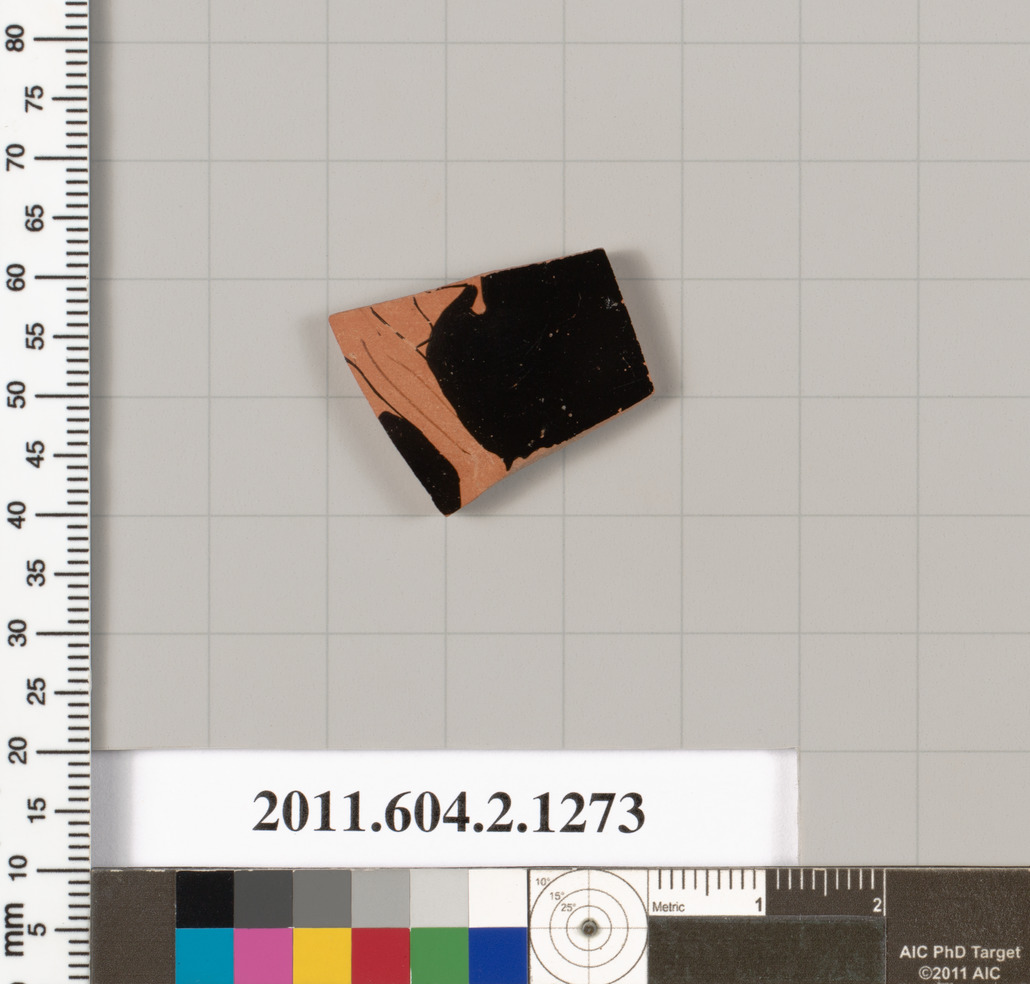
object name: skyphos fragment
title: Terracotta fragment of a skyphos (deep drinking cup)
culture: greek, attic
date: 460-440 BCE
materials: terracotta